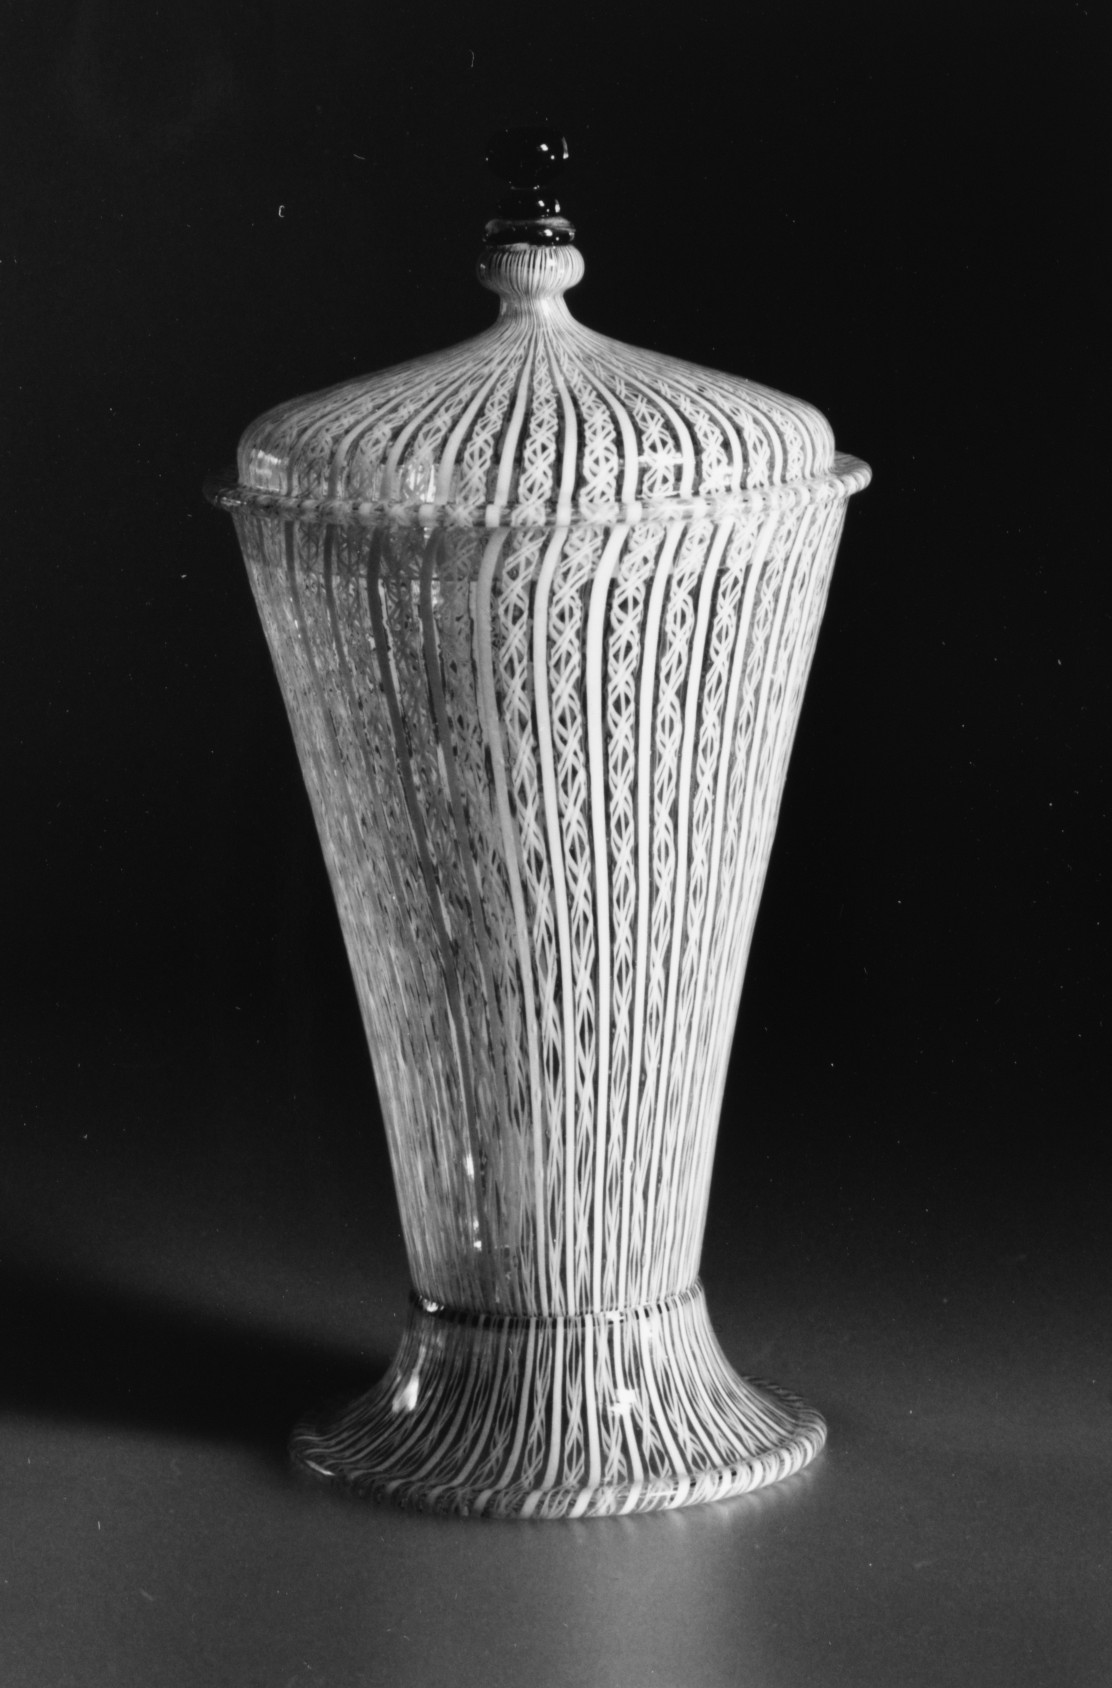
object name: covered beaker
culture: italian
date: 1501-1600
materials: glass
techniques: glassblowing